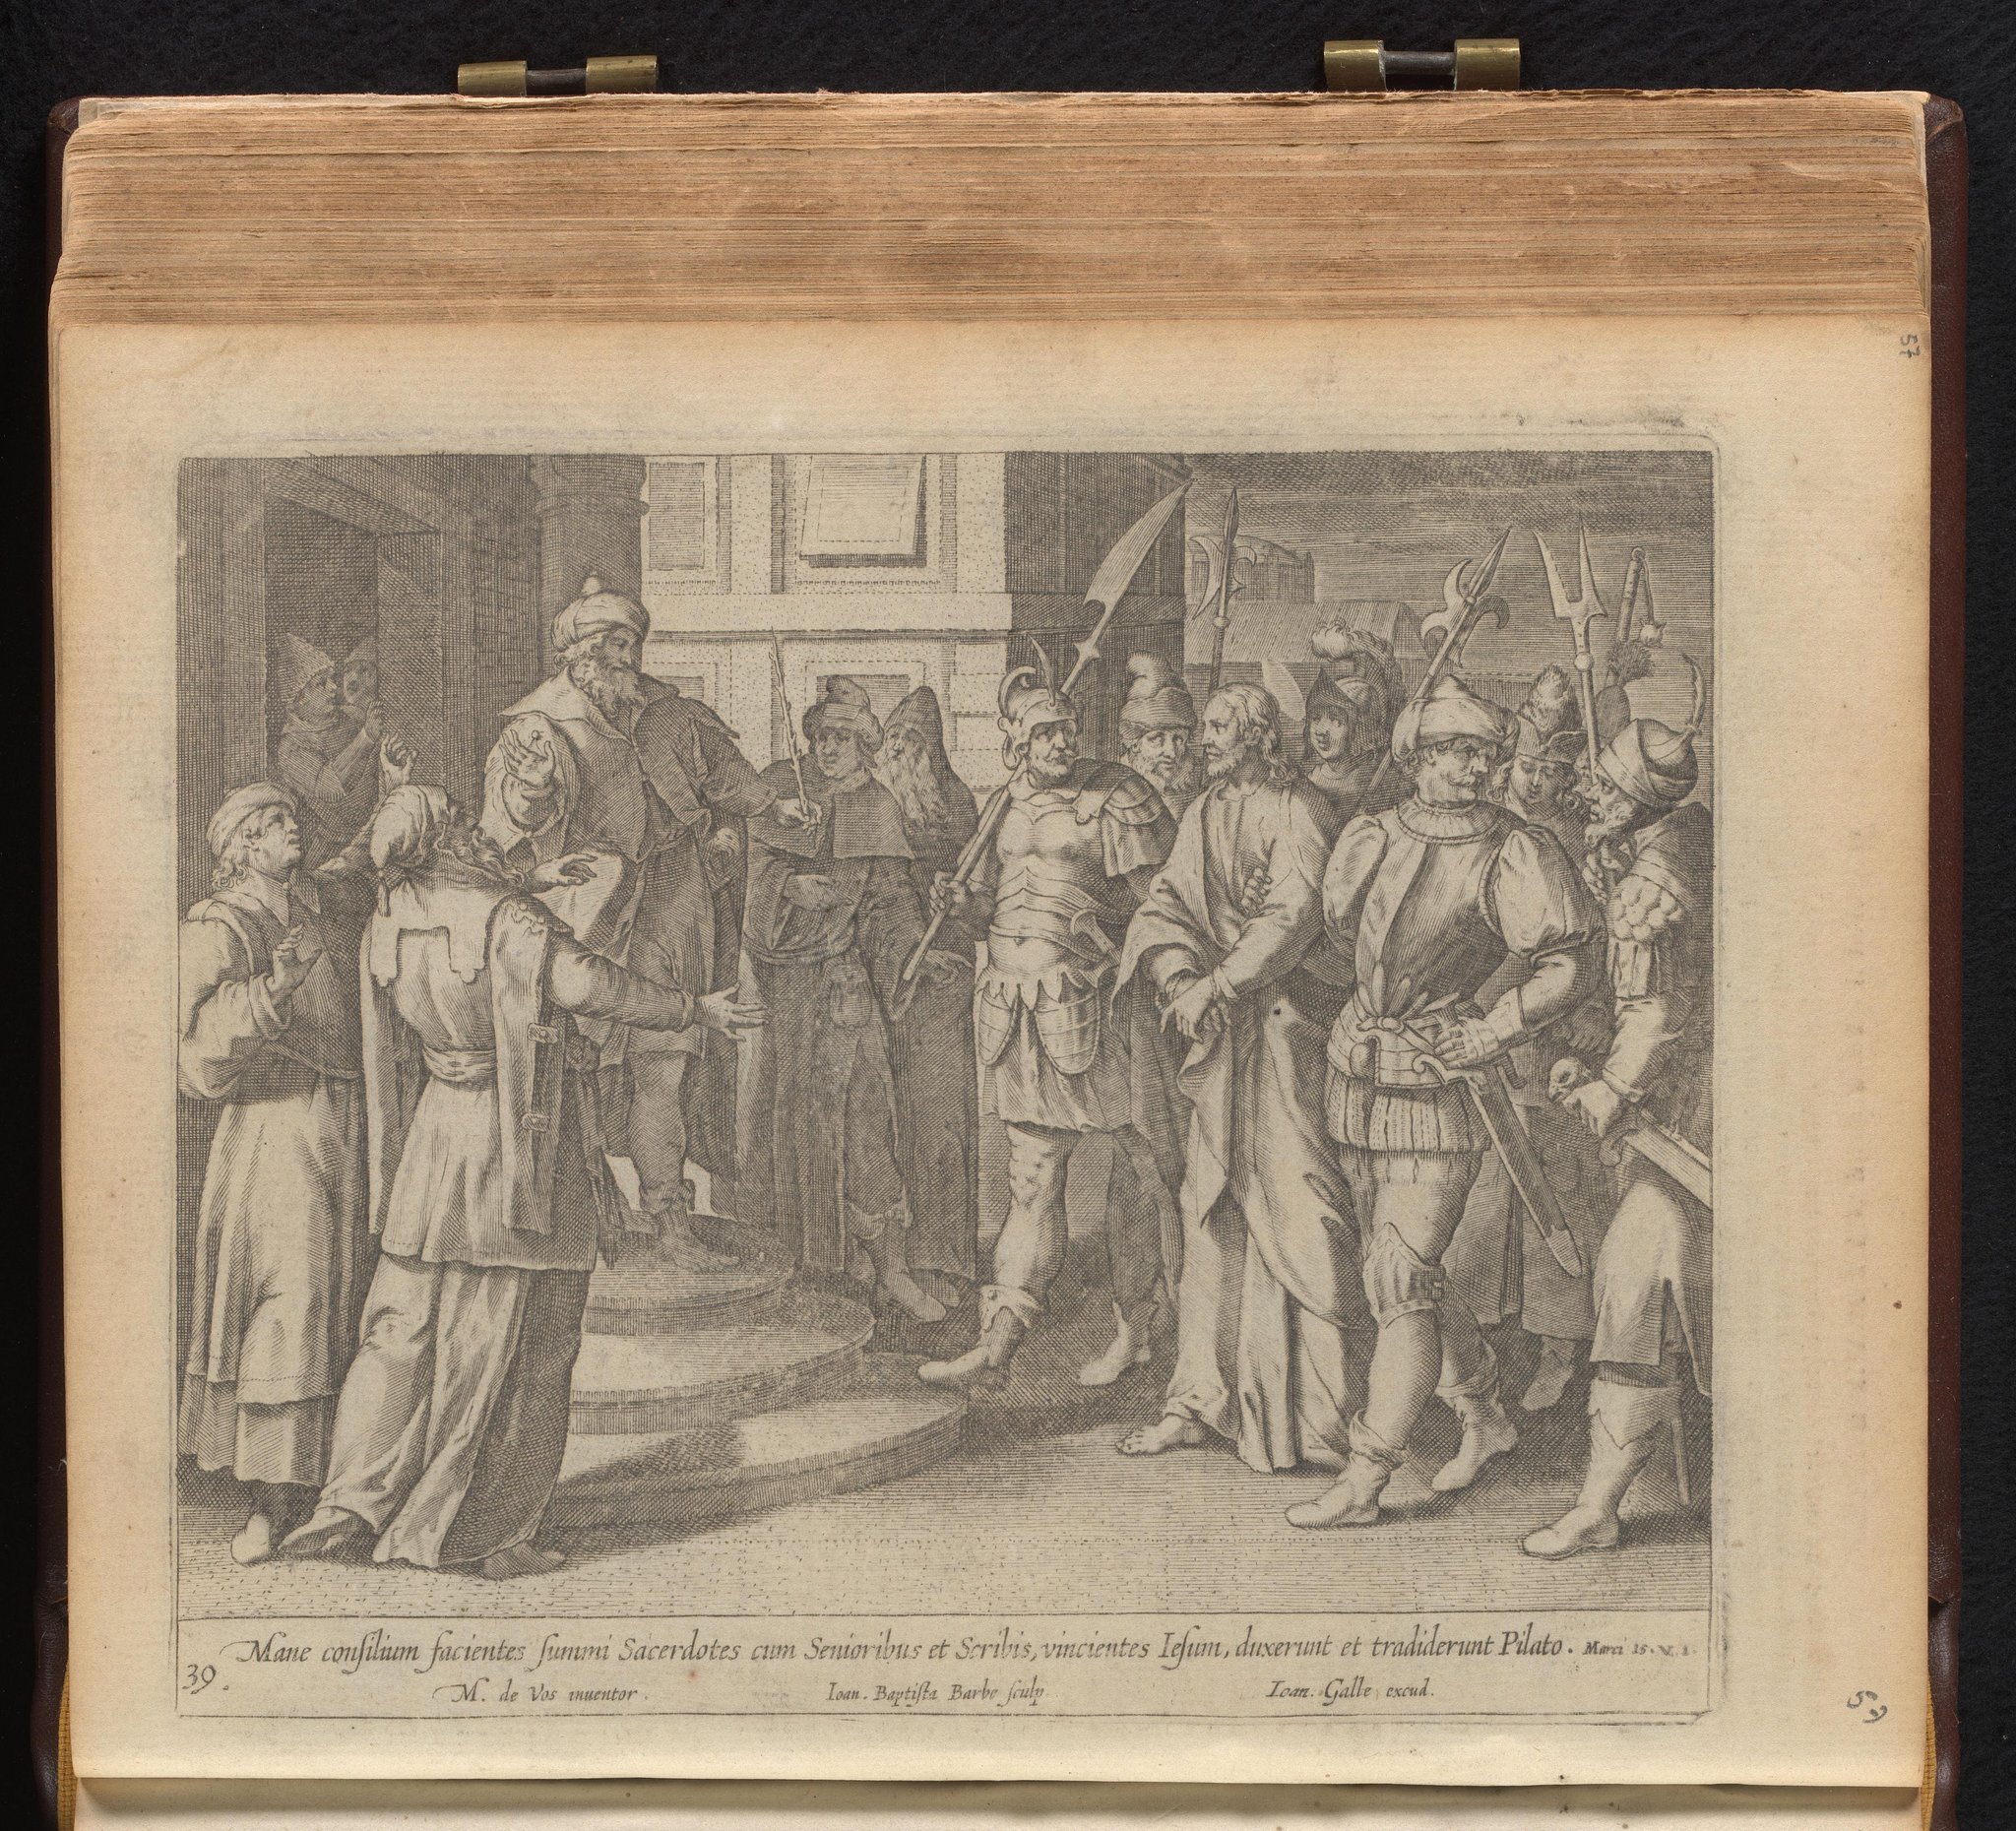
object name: print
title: Christus voor Pilatus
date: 1598-1618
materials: paper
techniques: engraving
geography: antwerp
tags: christ before pontius pilate (matthew 27:11-26; mark 15:2-15; luke 23:2-7, 23:13-25; john 18:28 - 19:16)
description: Prent maakt deel uit van een prentbijbel.